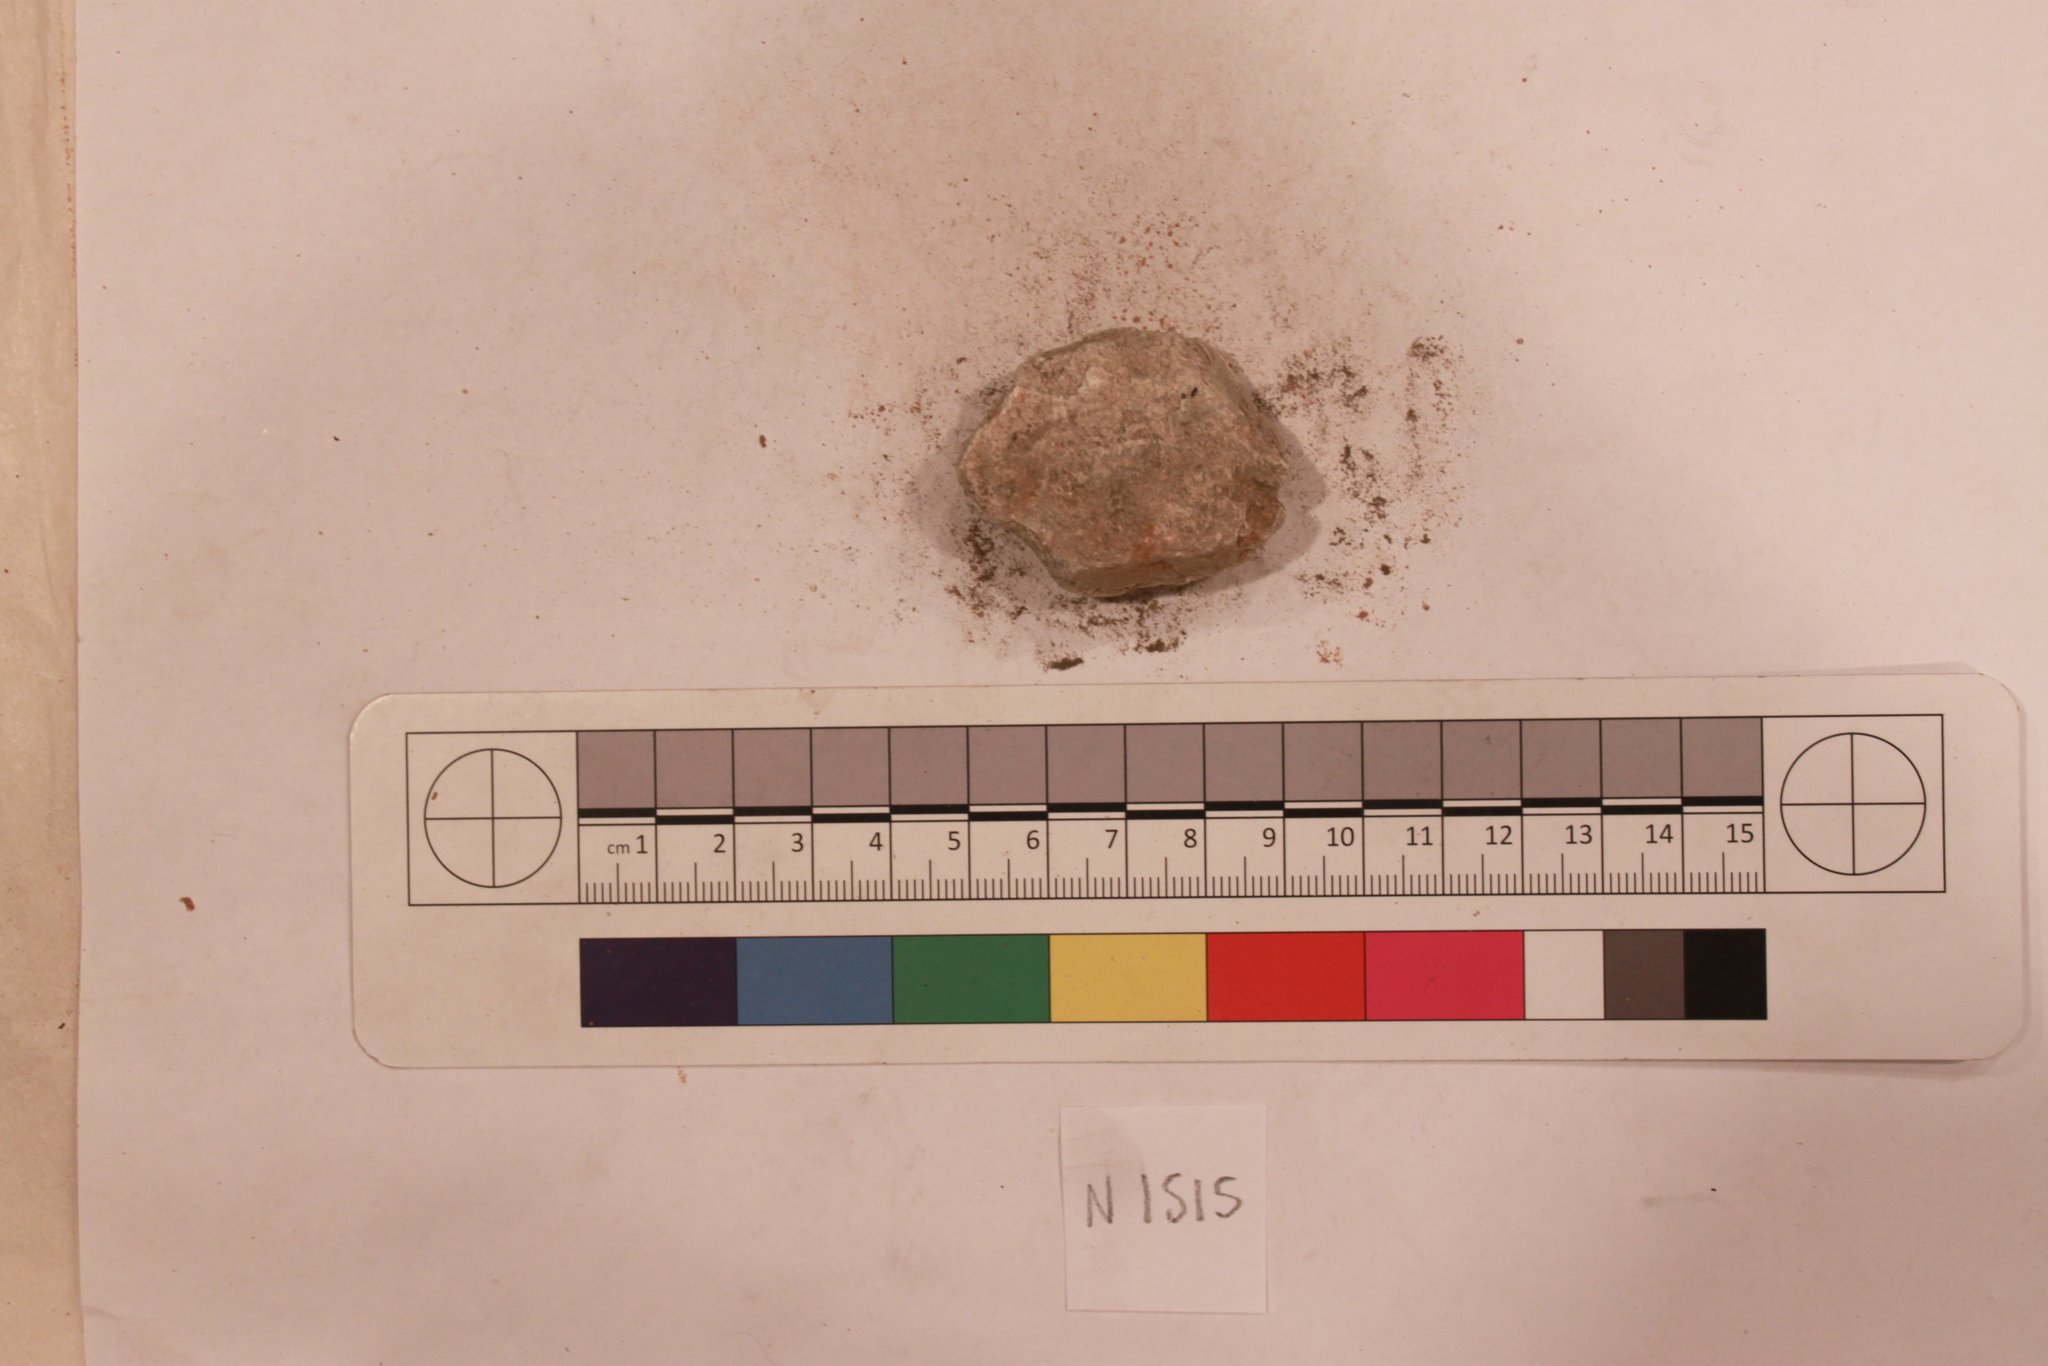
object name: fragment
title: Stucco Fragment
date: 701-1200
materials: plaster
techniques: carving, painting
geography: iran